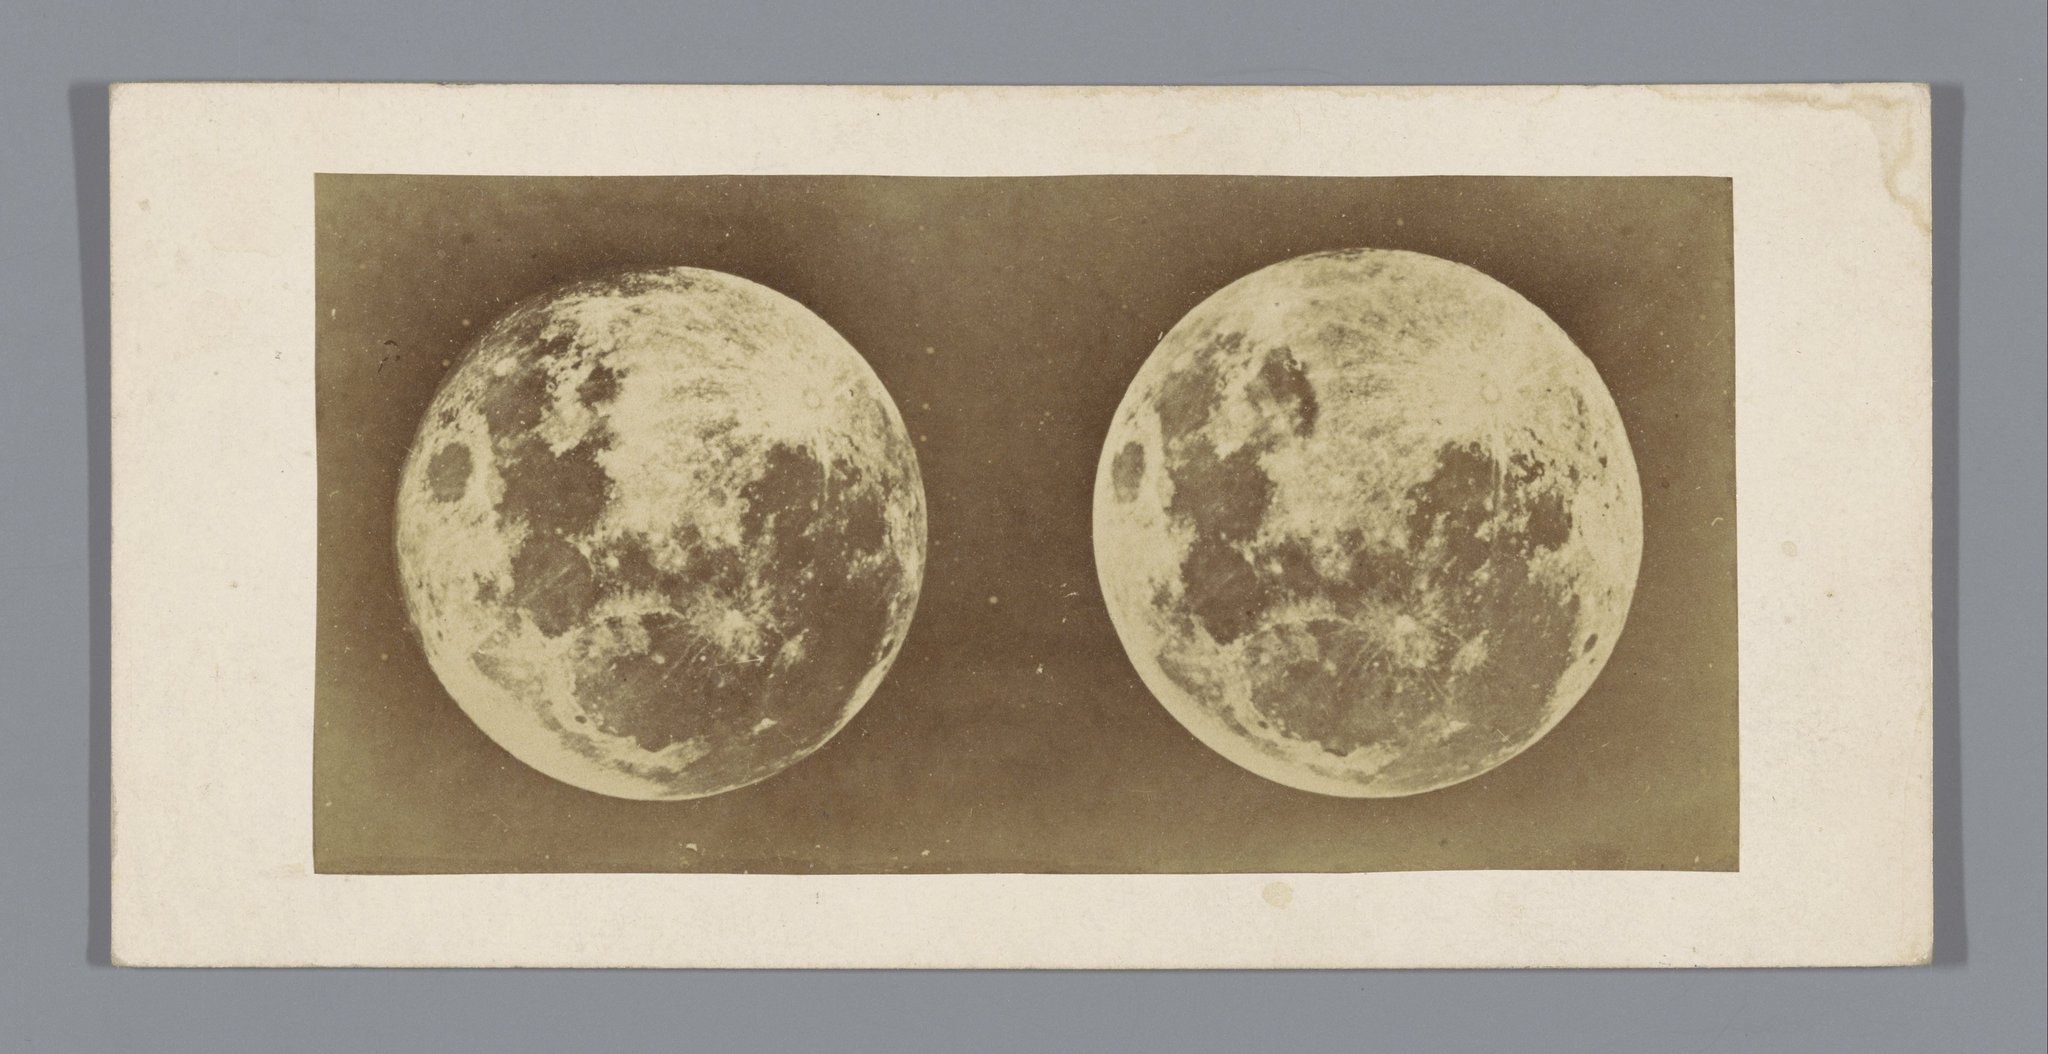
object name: stereograph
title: Stereoskopische afbeelding van de volle maan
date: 1858-1863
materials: cardboard, paper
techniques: albumen print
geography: amsterdam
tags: full moon, moon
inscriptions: address: ‘Water 110, te Amsterdam.’